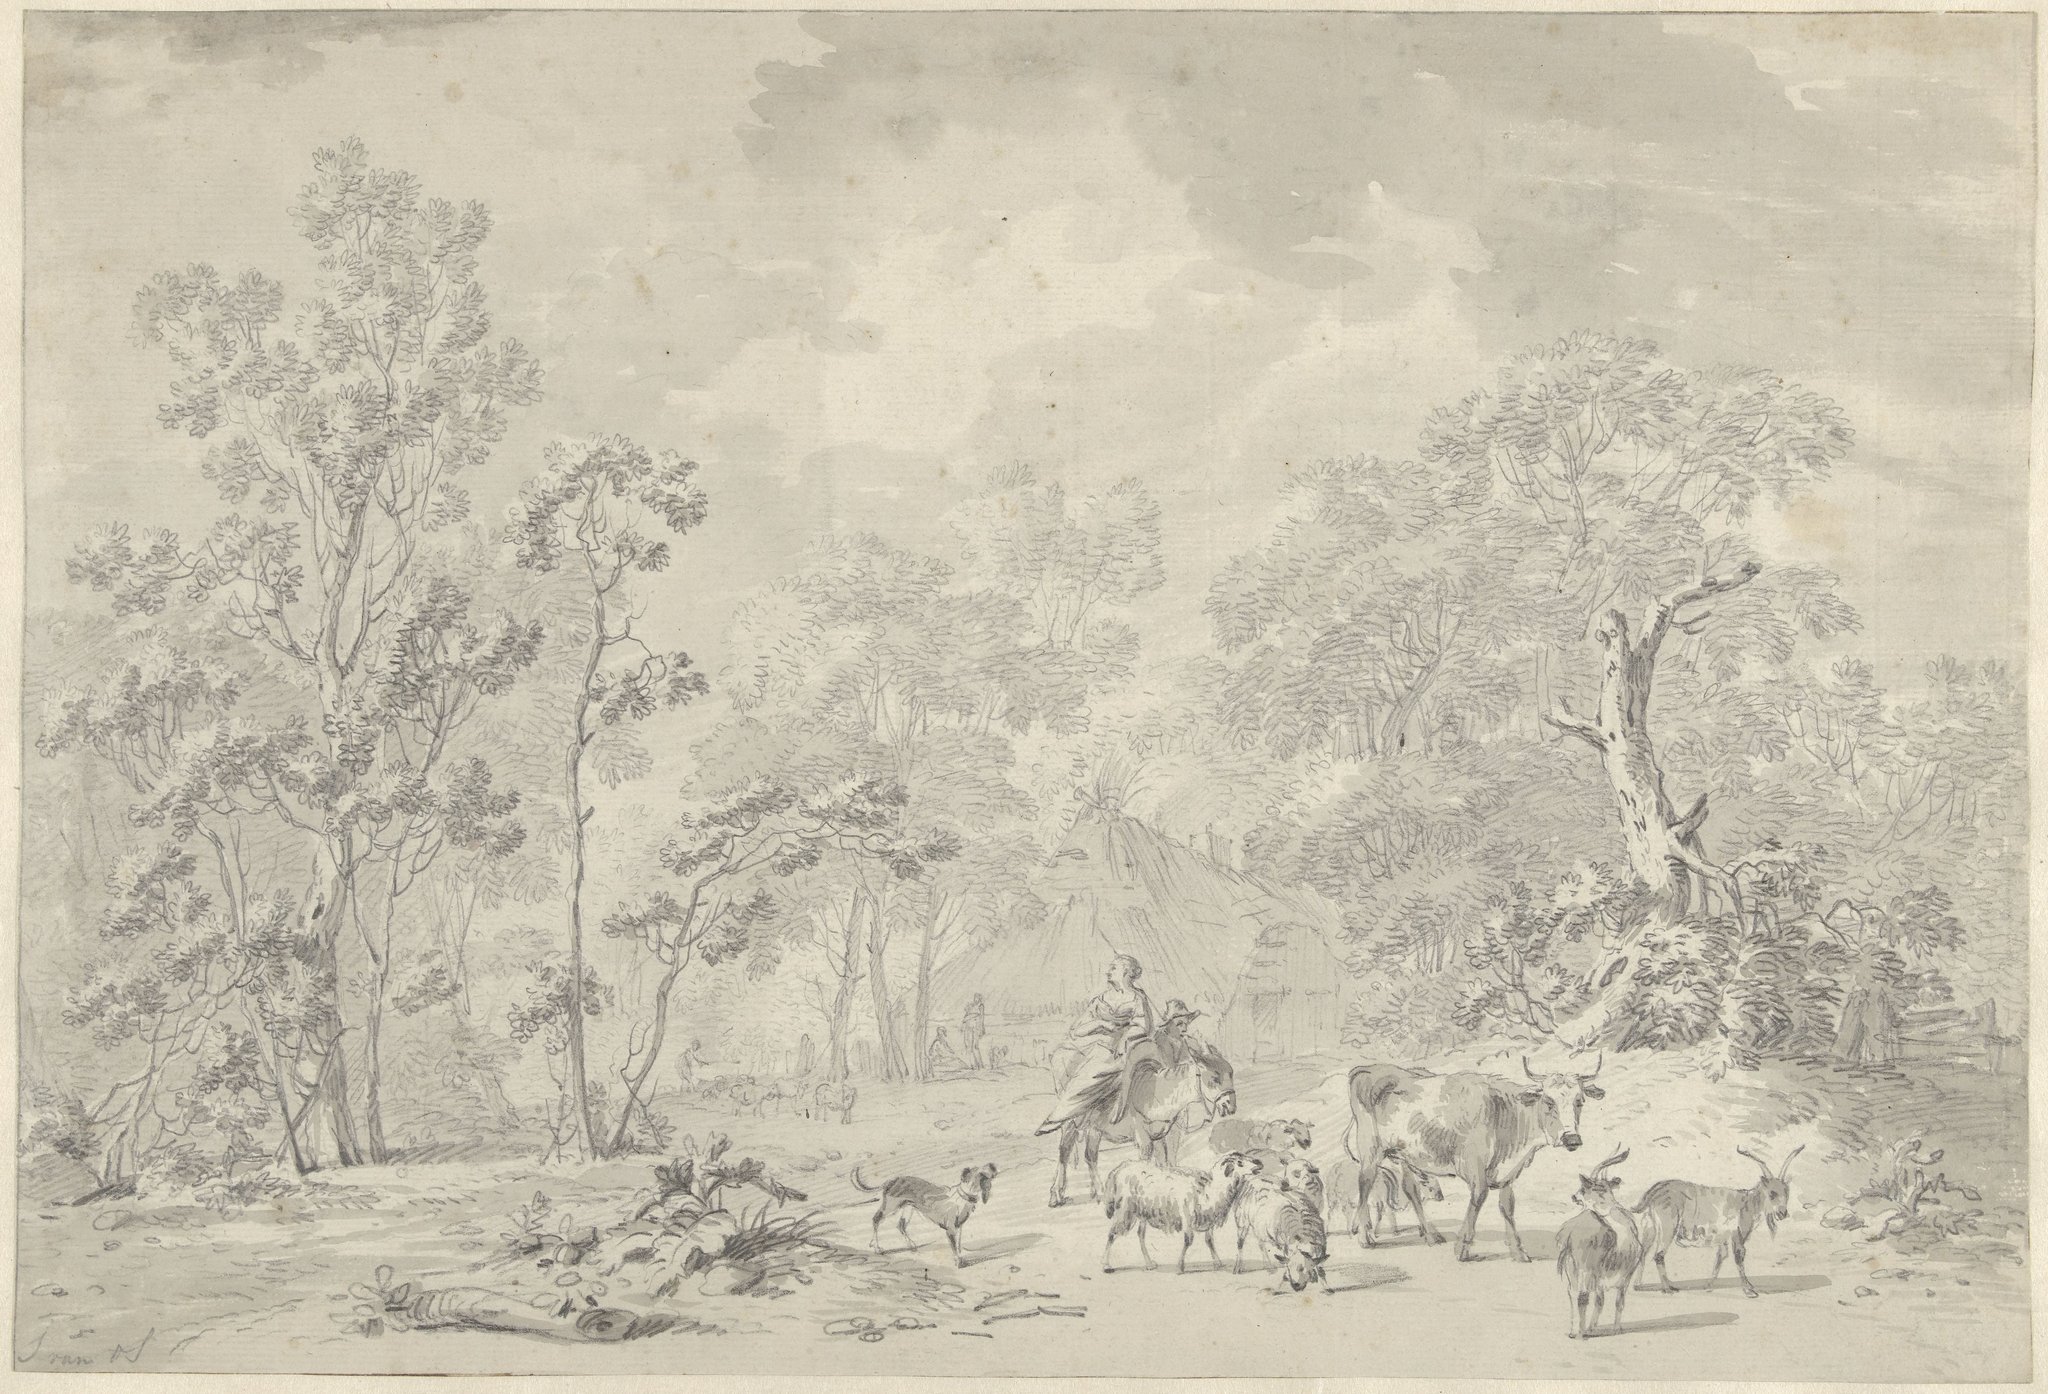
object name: drawing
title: Herder en vee in een boomrijk landschap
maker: jan van os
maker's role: draughtsman, painter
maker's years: 1744-1808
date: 1754-1808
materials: paper, pencil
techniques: brush